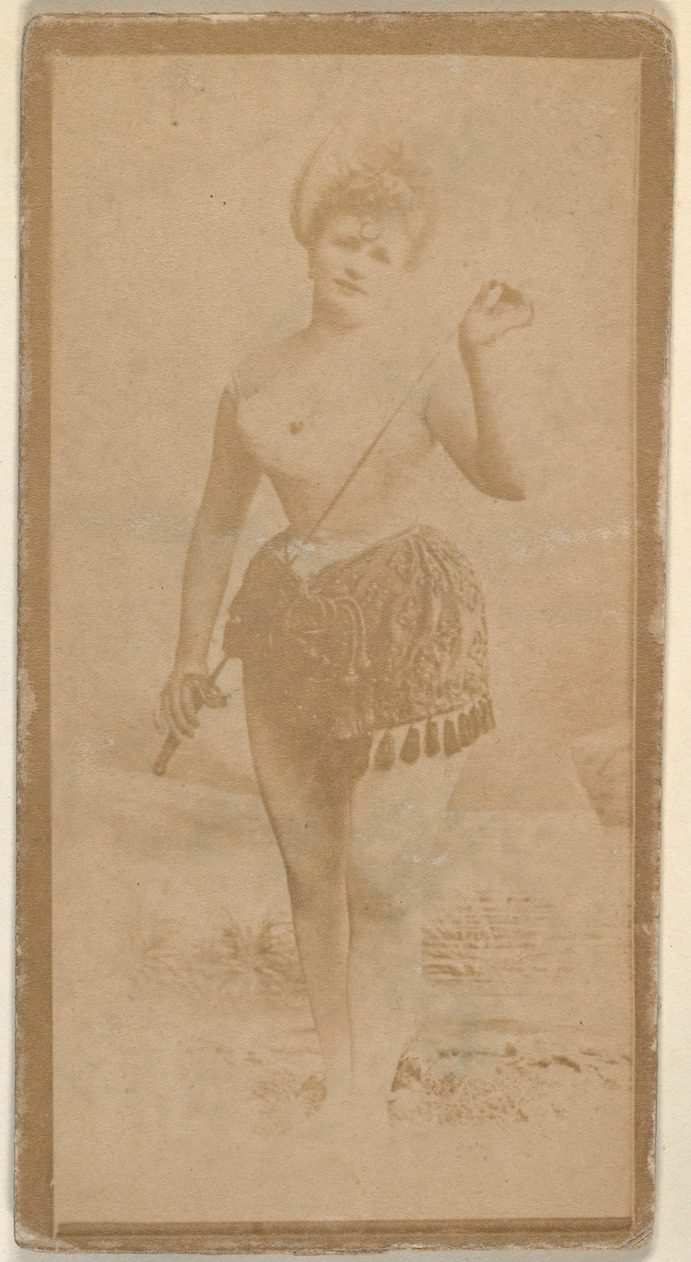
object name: photograph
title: Actress holding riding crop, from the Actresses series (N668)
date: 1888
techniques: albumen silver print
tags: portraits,women,actresses